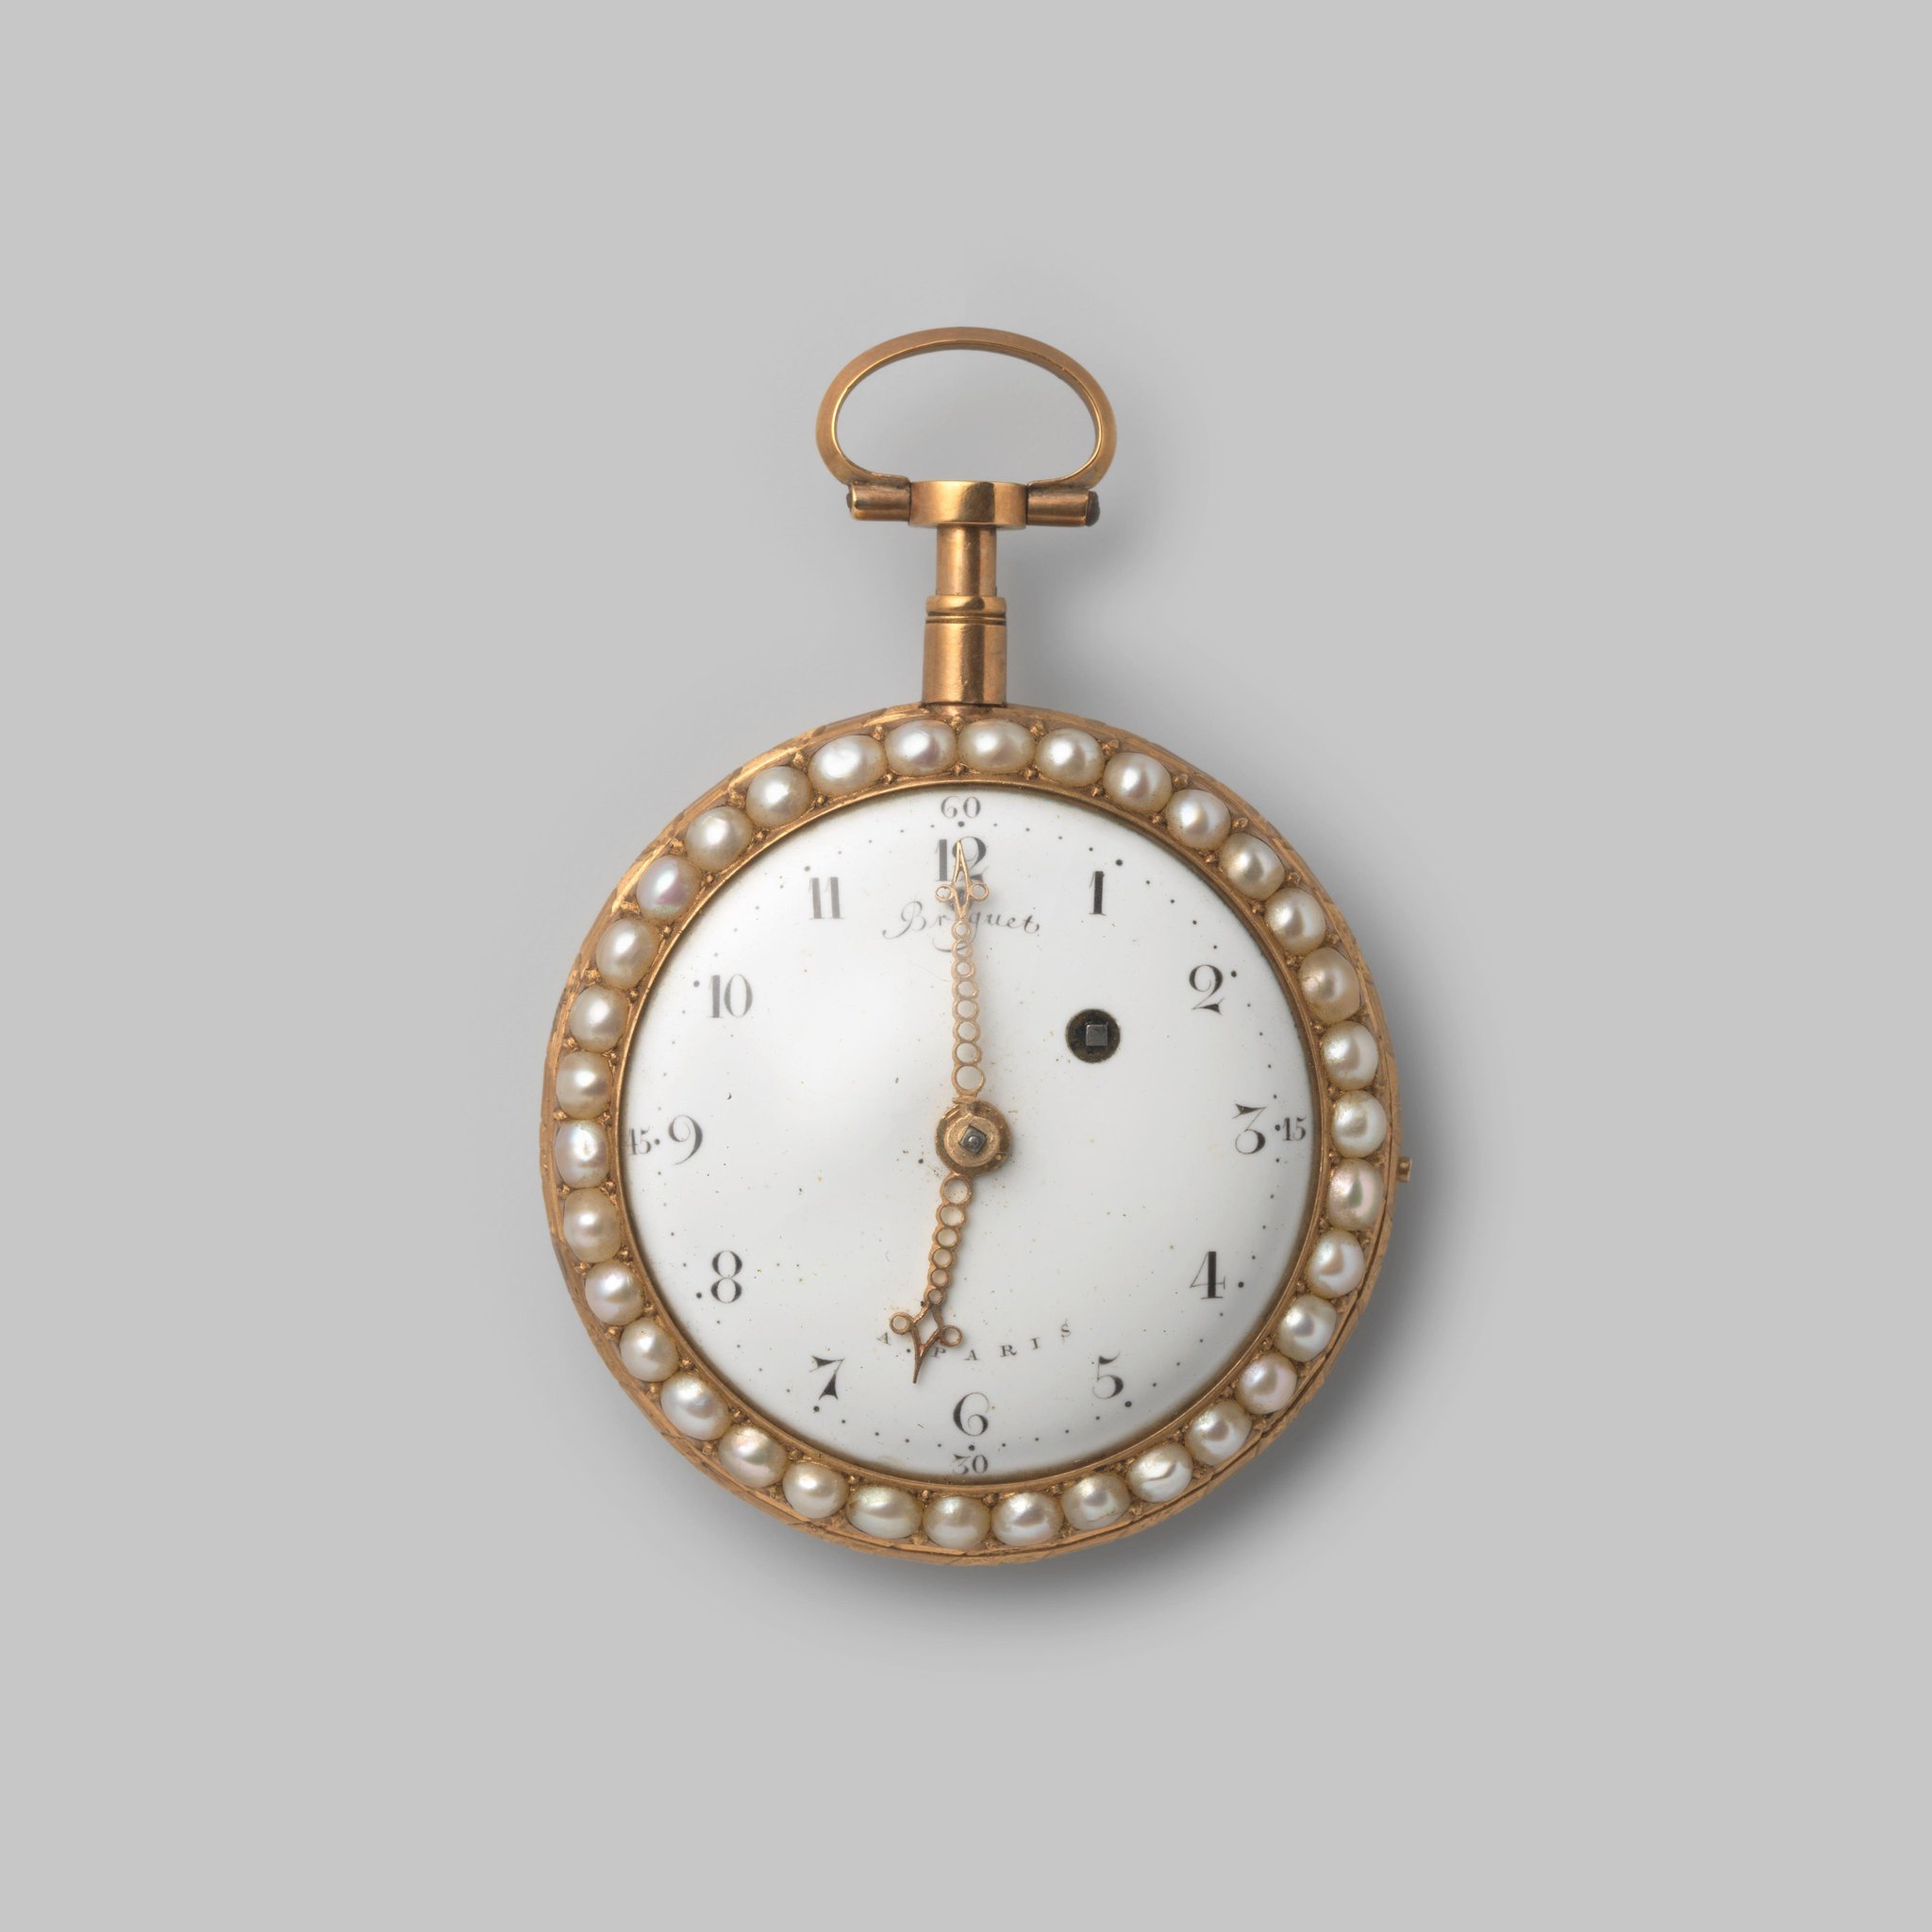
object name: jewellery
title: Horloge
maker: Anonymous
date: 1780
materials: gold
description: Gouden horloge met parelranden. Op de achterbodem een email schildering voorstellende een liefde's altaar. De wijzerplaat is gemerkt: Breguet à Paris, maar het betreft een eigentijdse vervalsing.